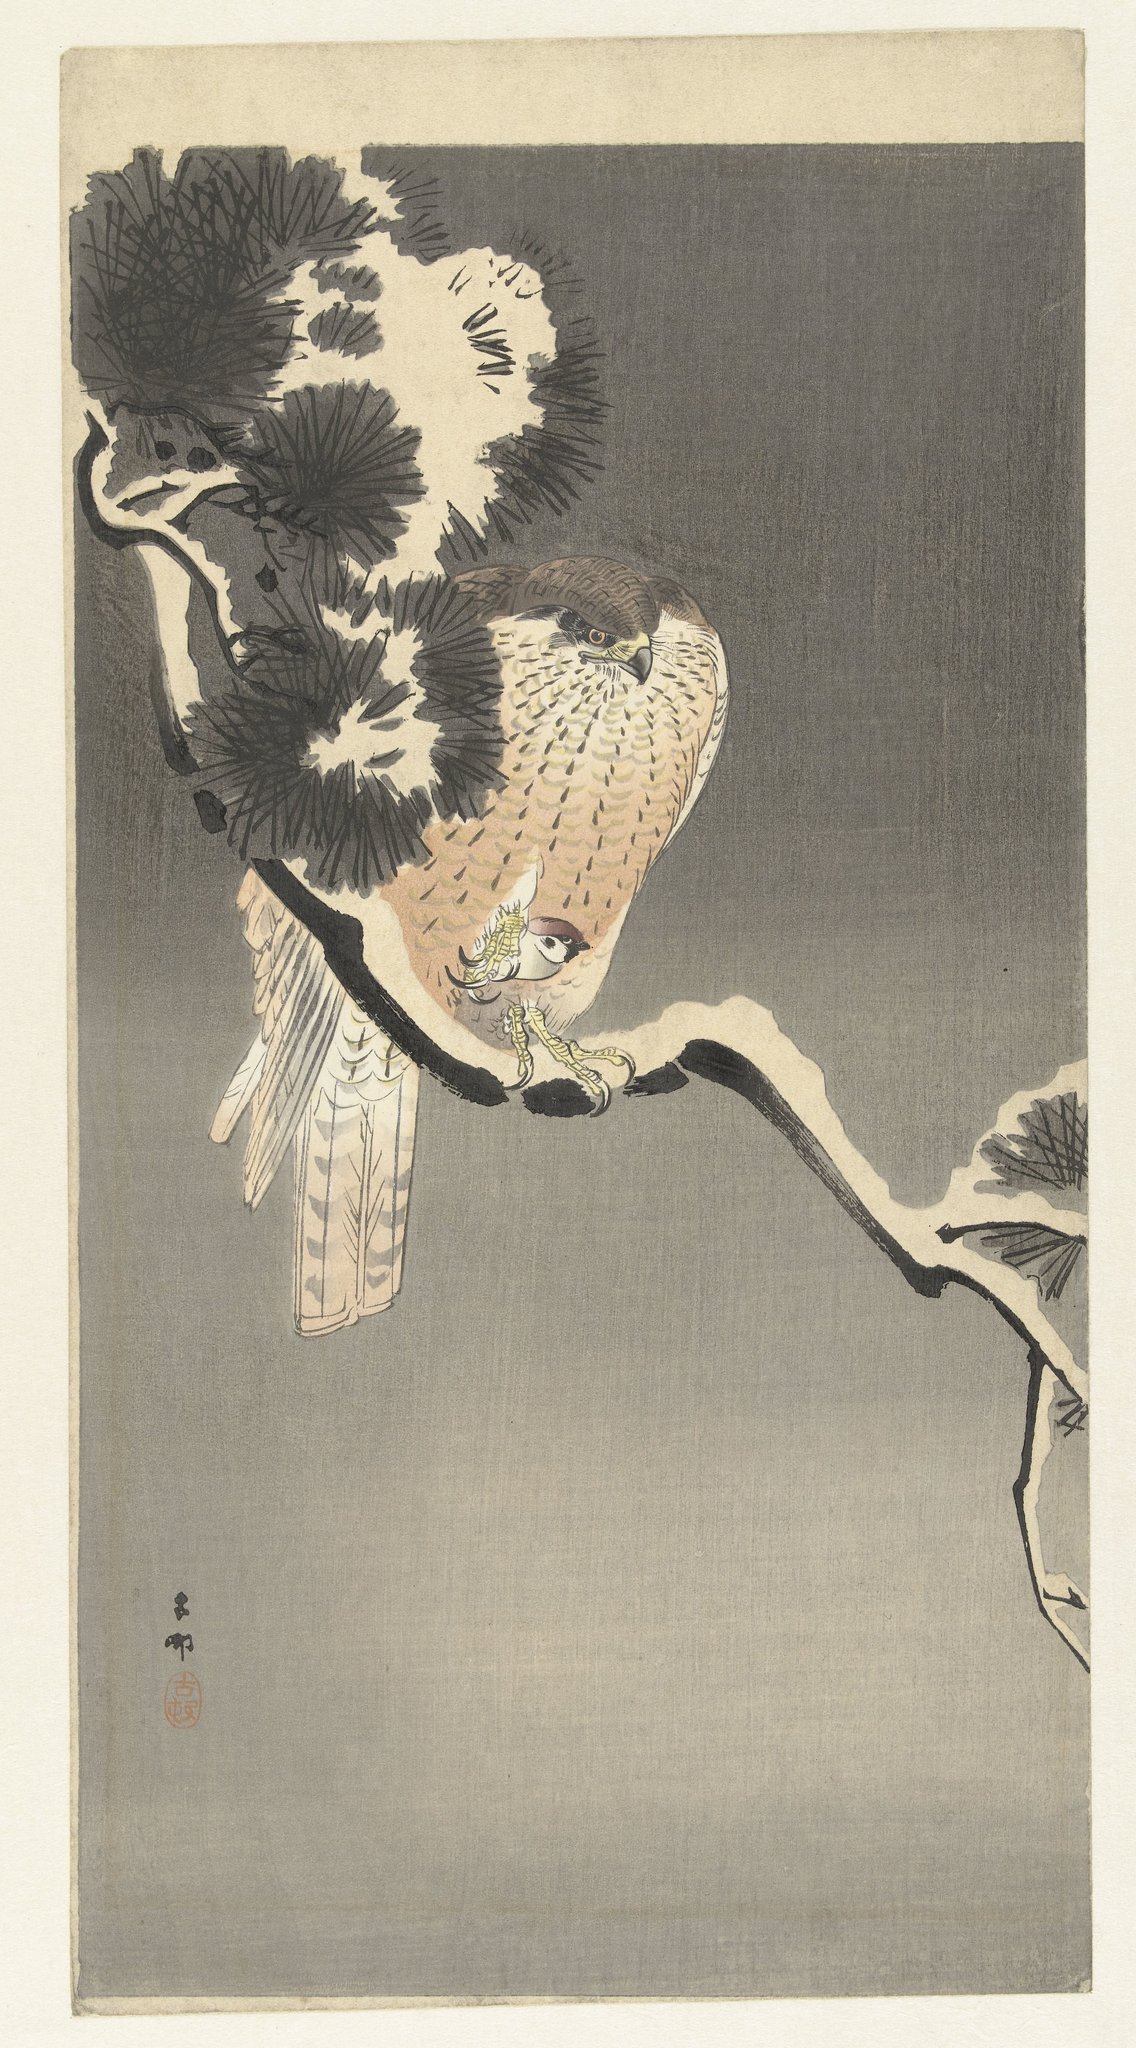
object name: print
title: Havik met mus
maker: ohara koson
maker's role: print maker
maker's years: 1877-1945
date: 1900-1930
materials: paper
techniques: woodcut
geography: tokyo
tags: predatory birds: hawk, song-birds: sparrow, trees: pine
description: Havik met mus in rechter klauw, zittend op besneeuwde tak van pijnboom.